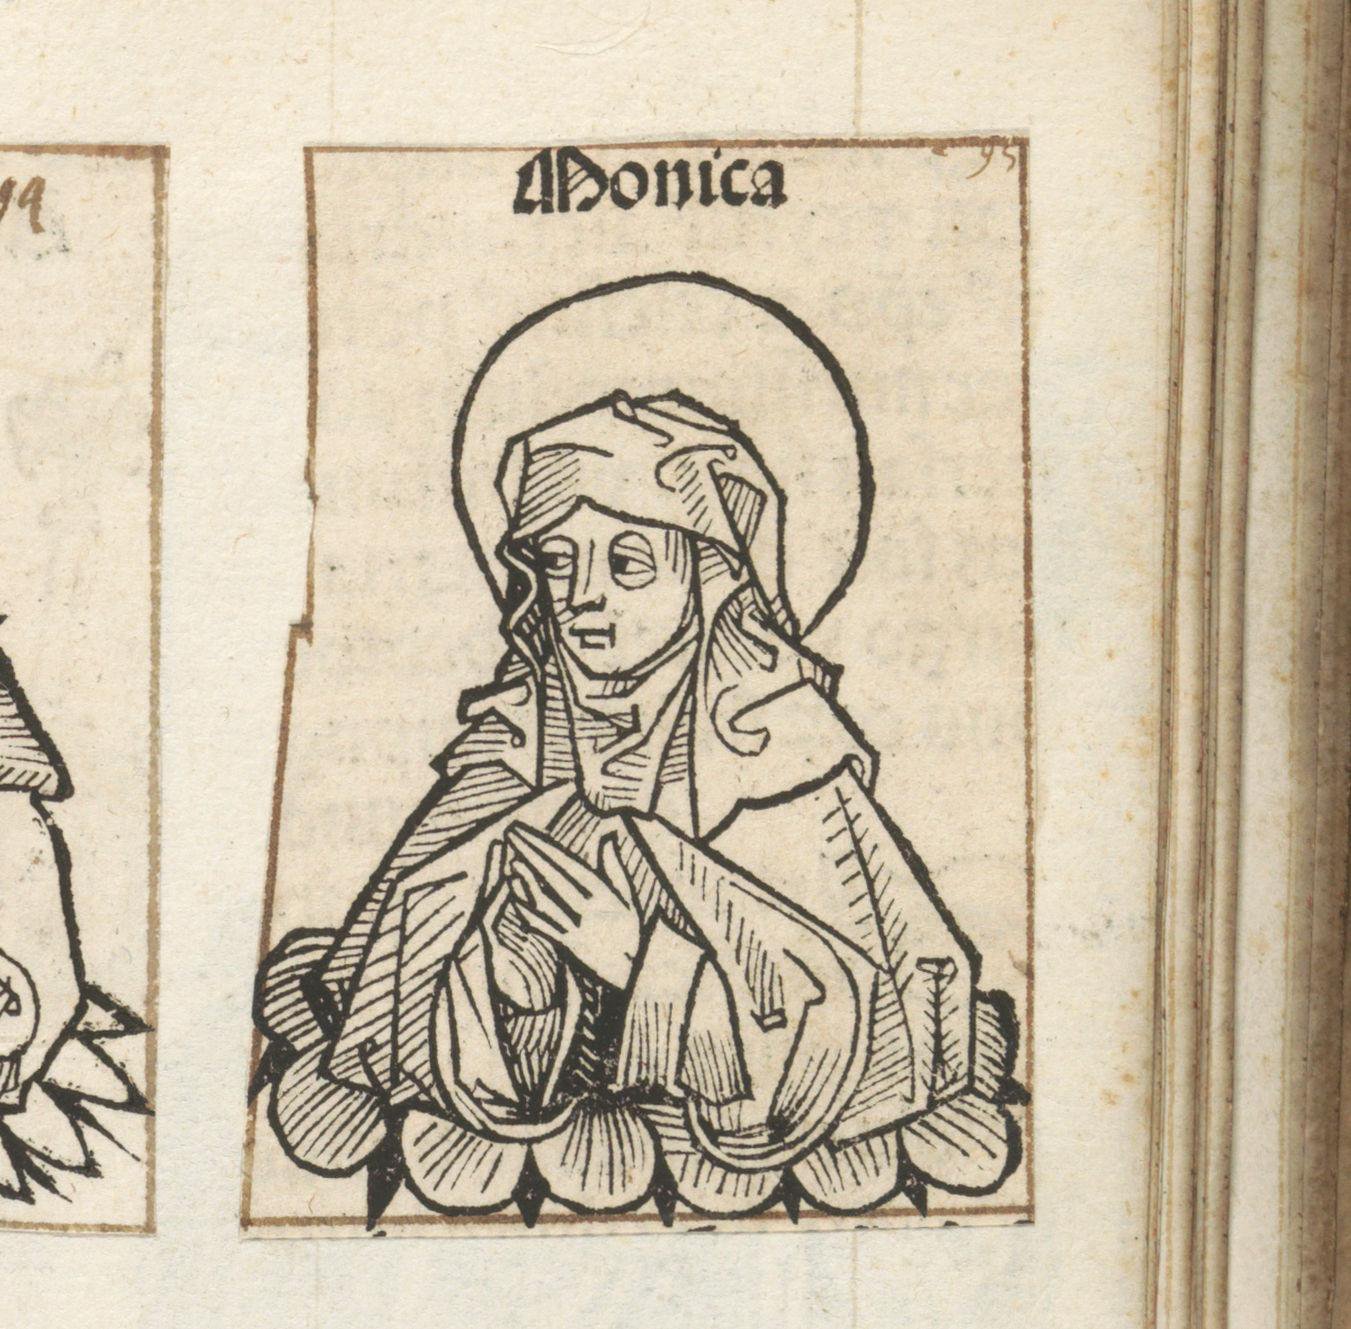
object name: album leaf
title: Monica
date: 1493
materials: paper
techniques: letterpress printing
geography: nuremberg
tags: female saints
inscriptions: inscription: ‘95’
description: De houtsnede wordt herhaaldelijk gebruikt als boekillustratie in de Liber Chronicarum (of Neurenbergkroniek) van Hartmann Schedel, verschenen in het Latijn en Duits in 1493. Zie de Latijnse uitgave, folio 136r.